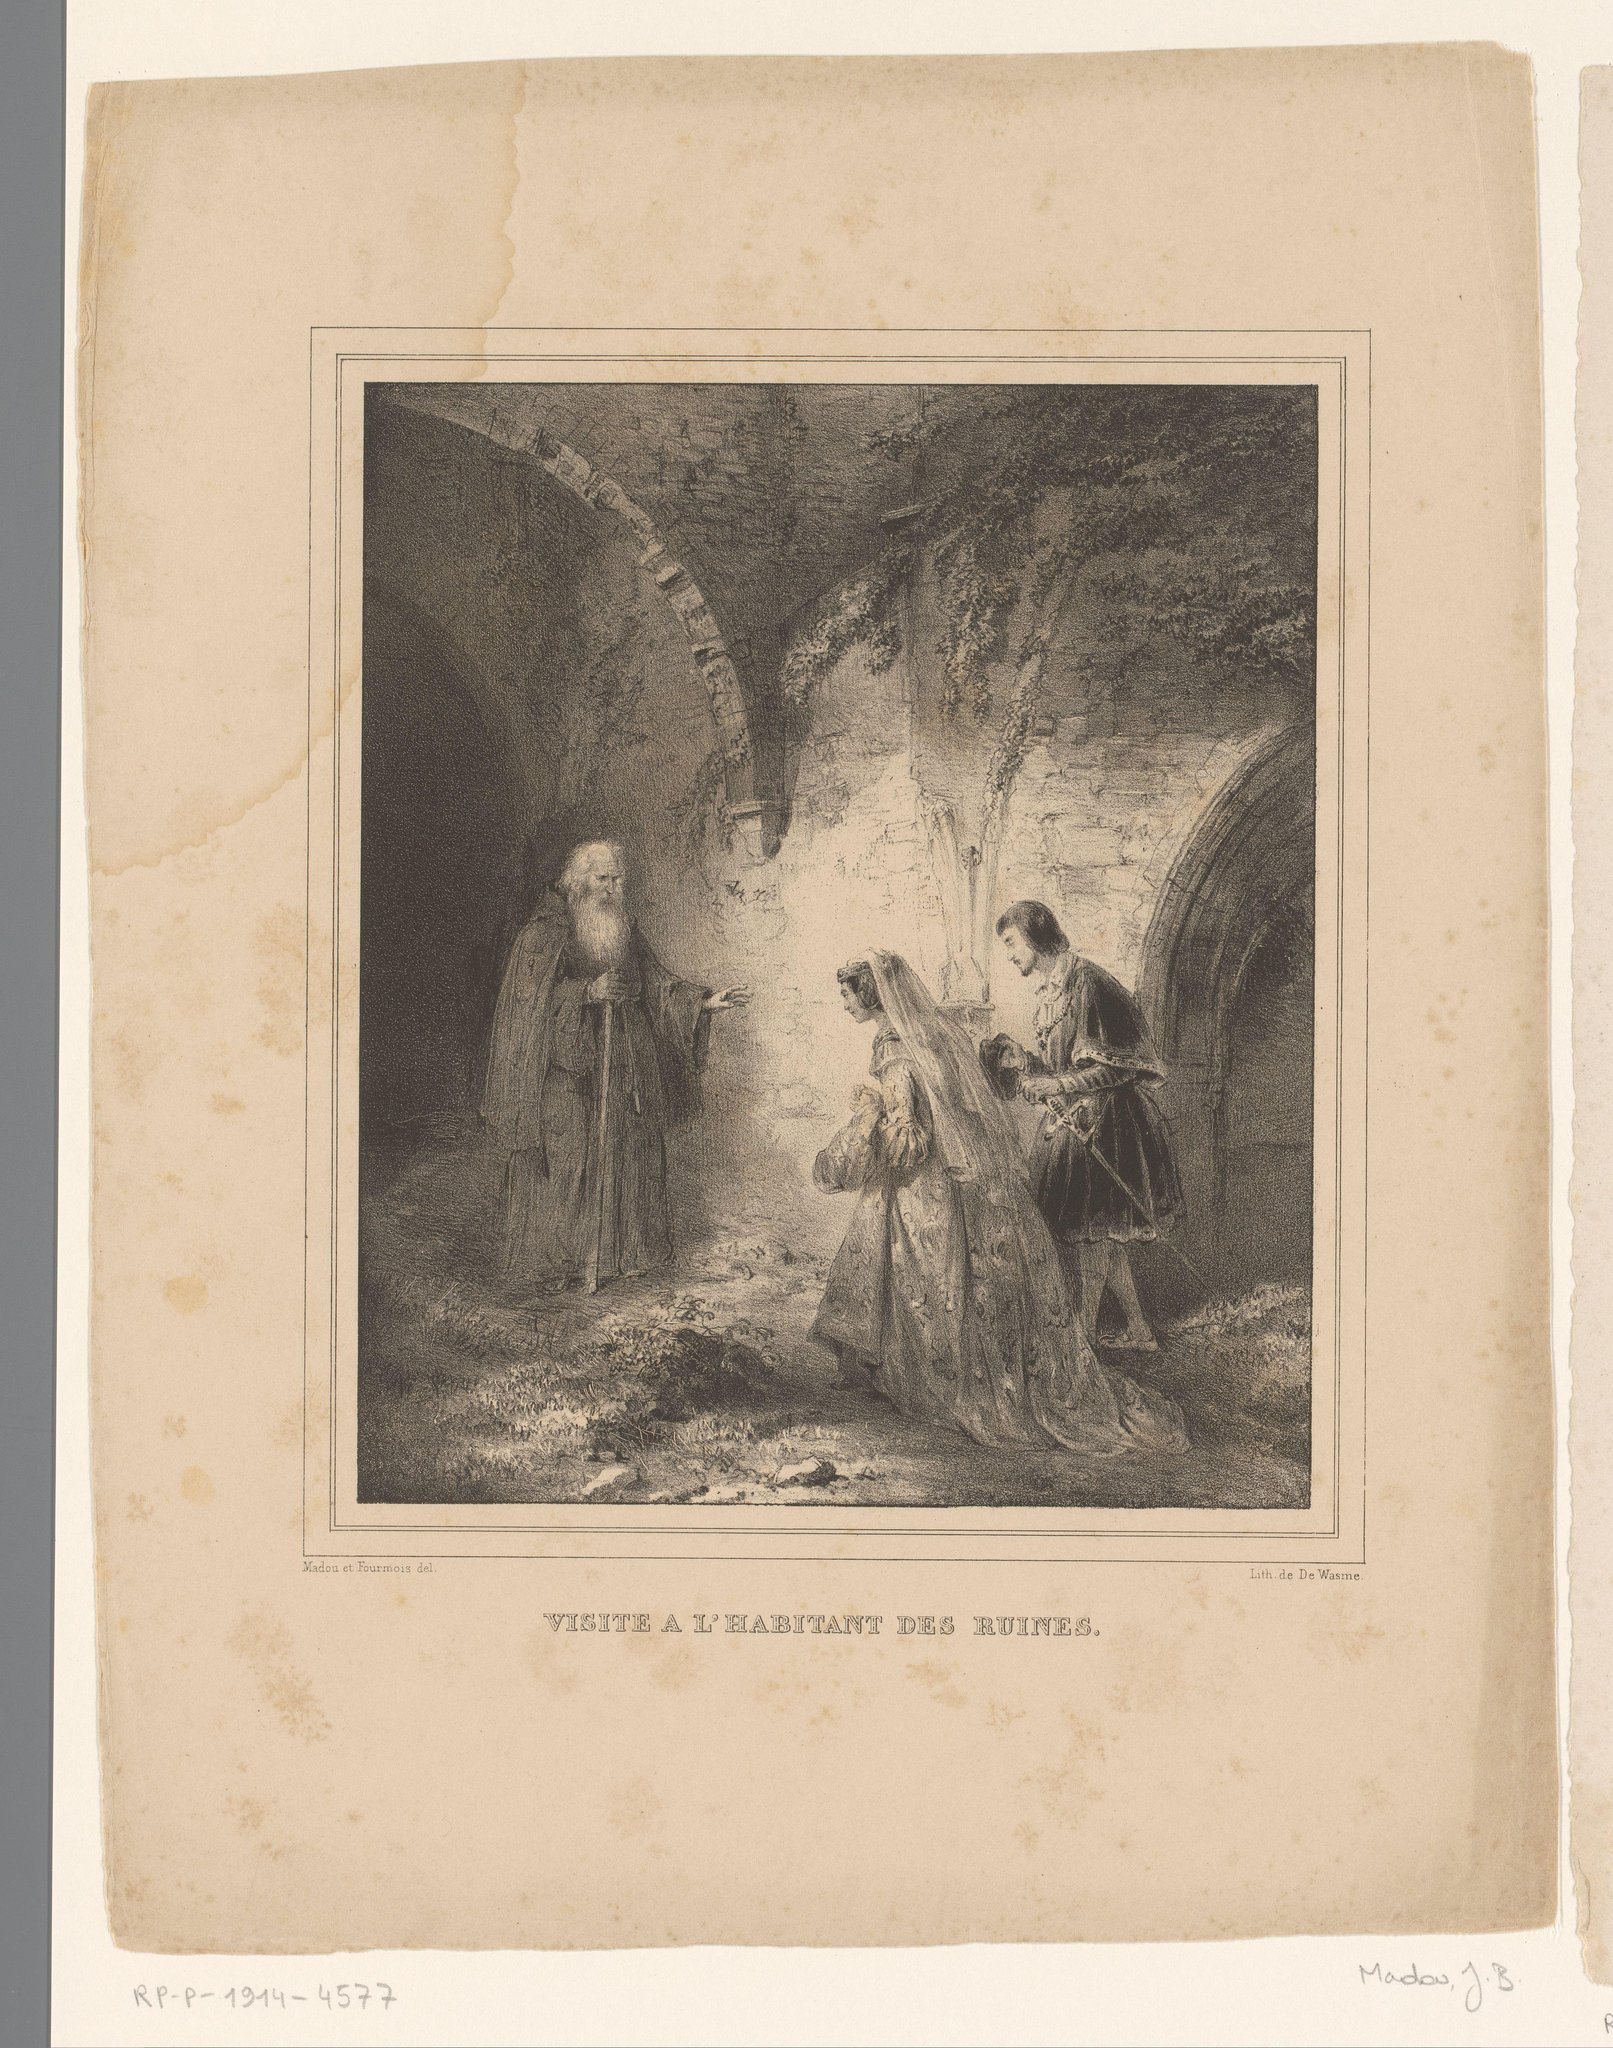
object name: print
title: Visite a l'habitant des ruines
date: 1834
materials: paper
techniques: lithograph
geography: brussels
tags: visiting; receiving guests; elegant company, landscape with ruins (+ city(-scape) with figures, staffage)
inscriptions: collector's mark: Lugt 2228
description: Prent behoort tot een serie met twaalf genretaferelen vervaardigd door Madou en Fourmois. Vier prenten zijn enkel door Madou vervaardigd en de overige prenten door Madou en Fourmois samen. Madou vervaardigde de figuren en Fourmois het landschap.